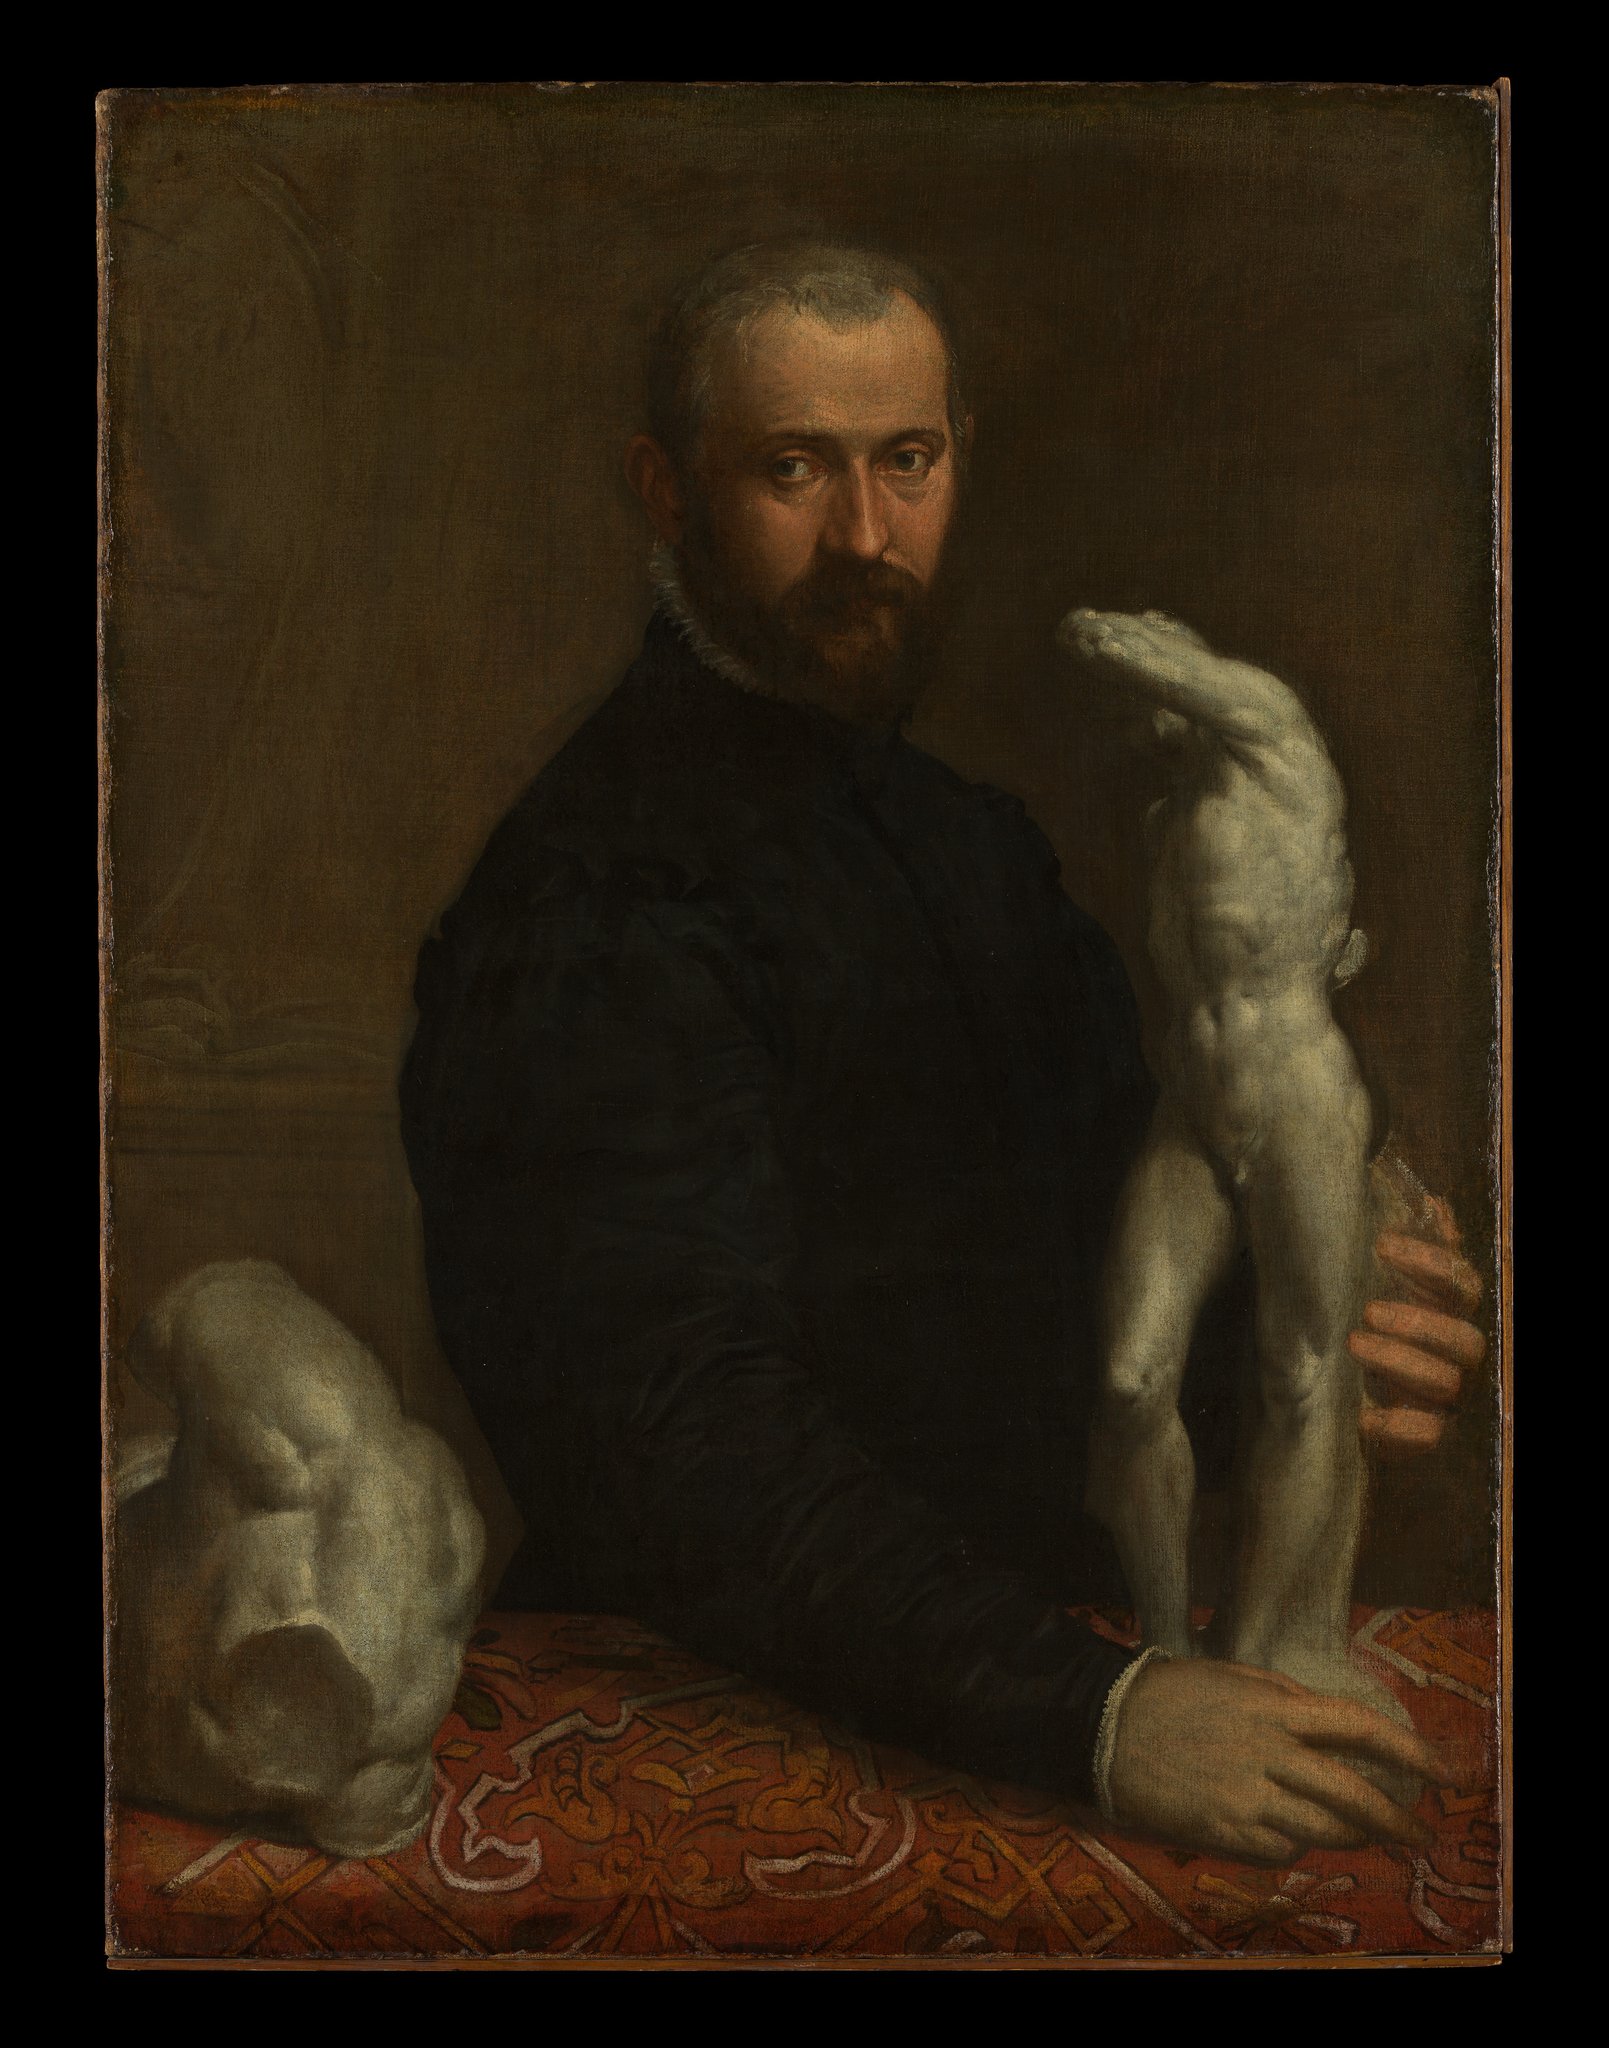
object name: painting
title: Alessandro Vittoria (1525–1608)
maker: paolo veronese (paolo caliari)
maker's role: artist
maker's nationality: italian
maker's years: 1528-1588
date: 1580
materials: canvas, oil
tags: men,portraits,artists